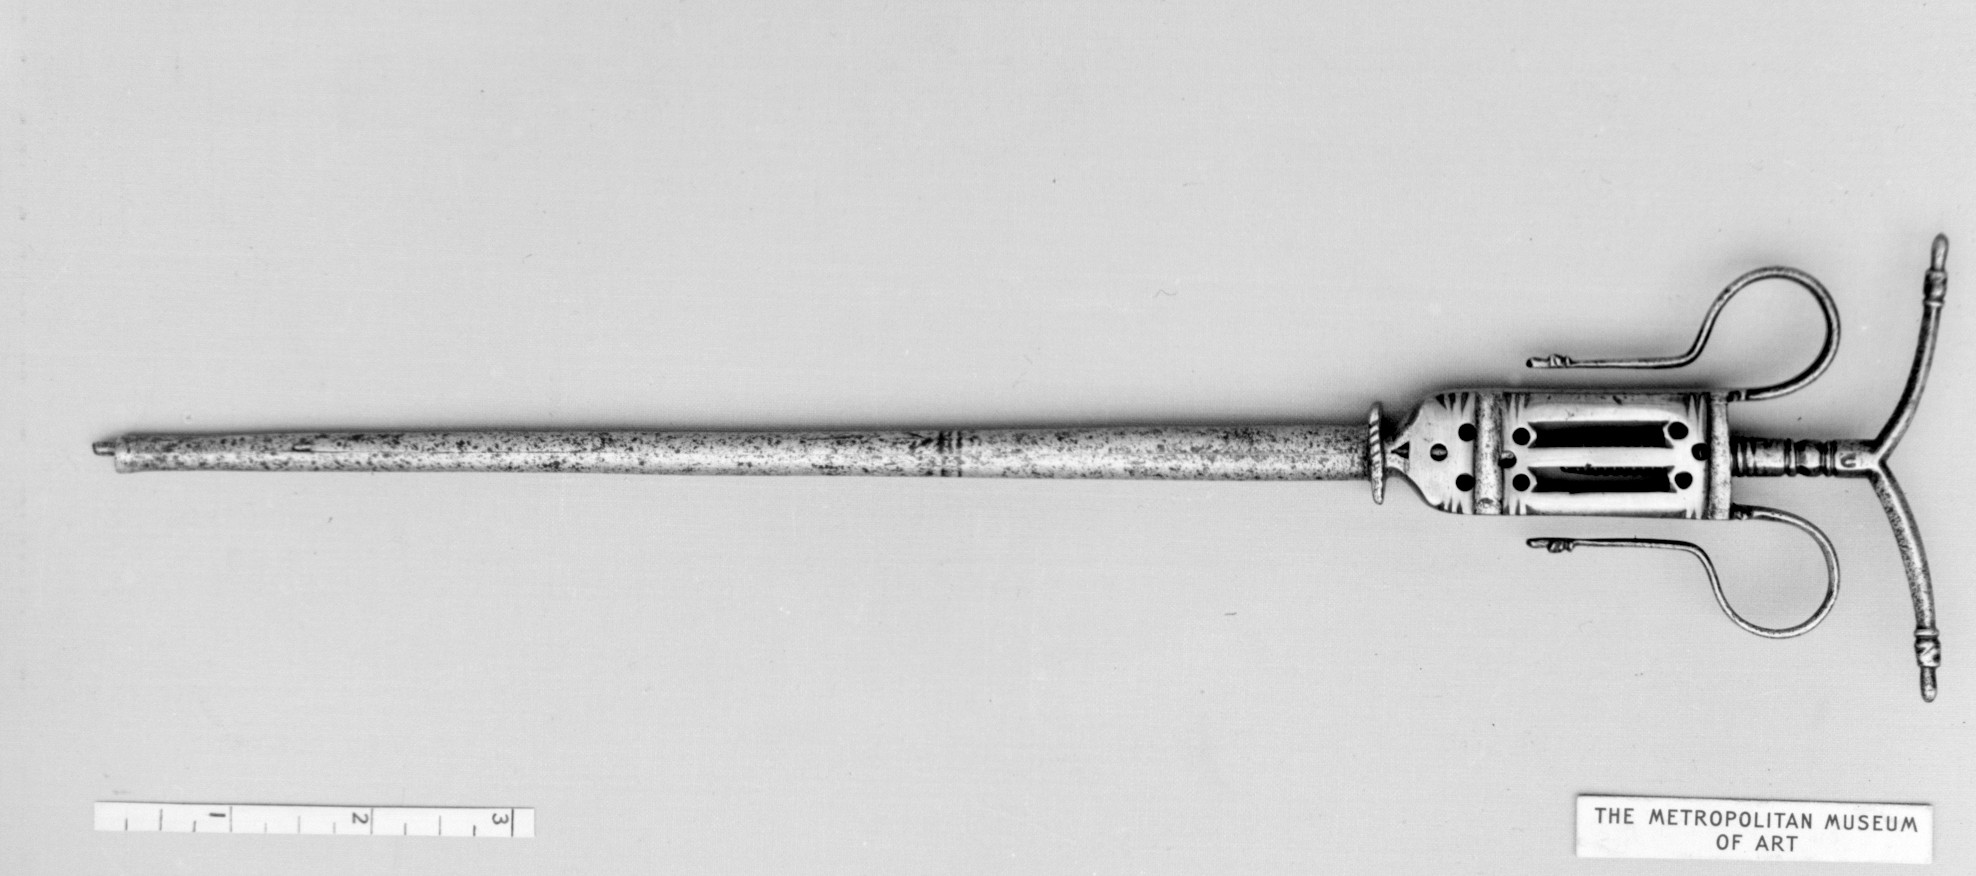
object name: screw bullet extractor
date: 1601-1700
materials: steel